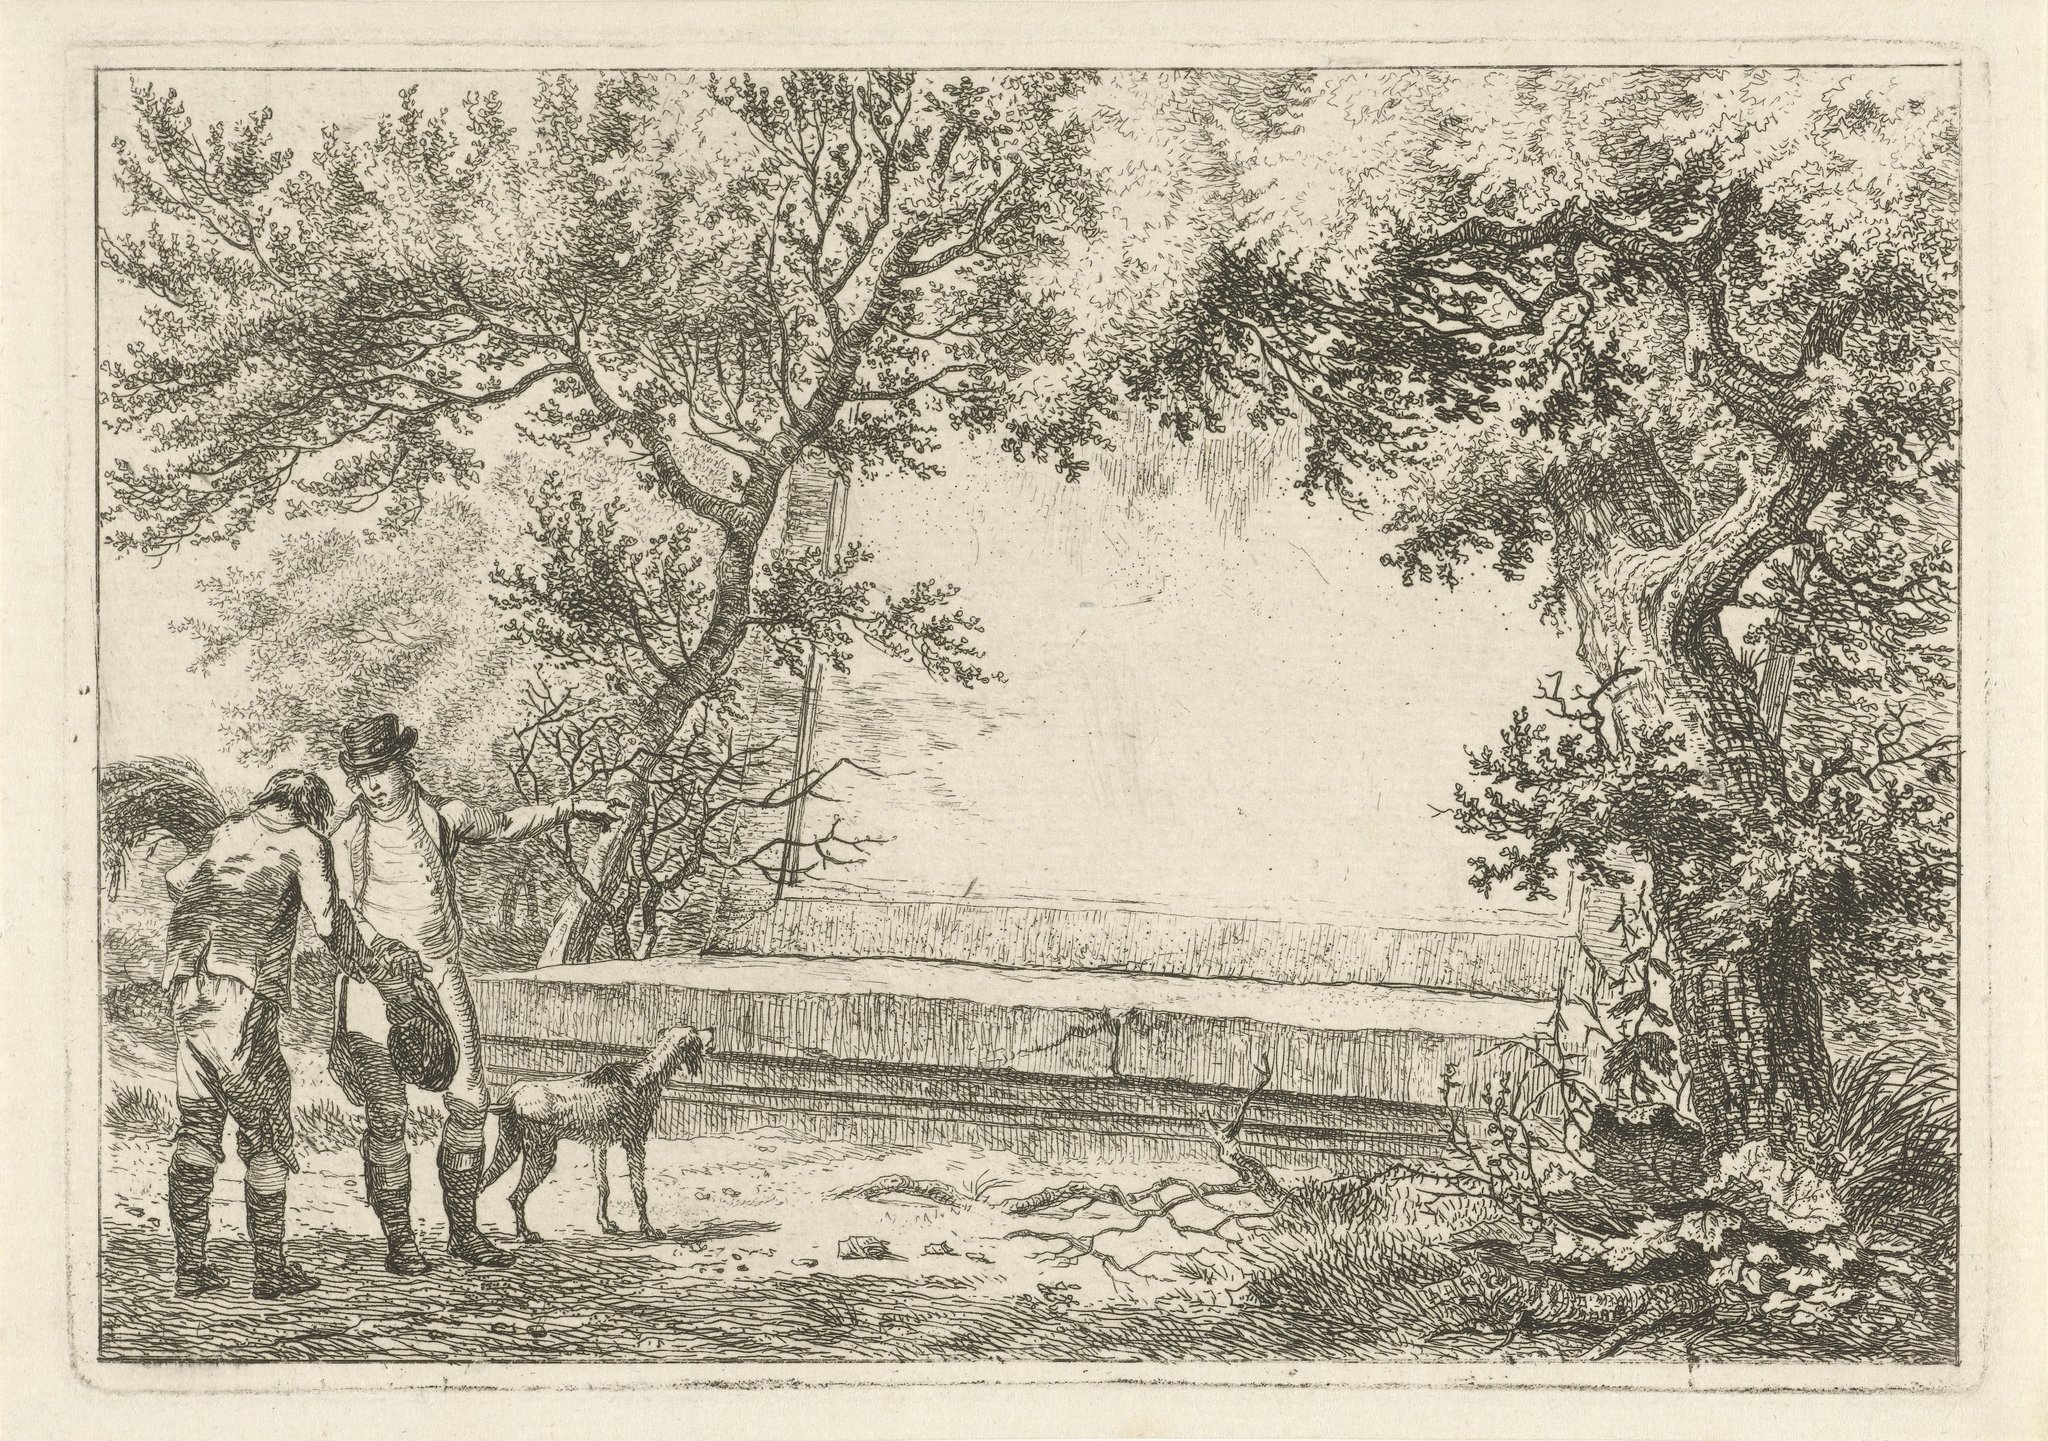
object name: print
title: Twee mannen bij stenen cartouche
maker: hermanus fock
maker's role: conservator, draughtsman, painter, print maker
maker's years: 1766-1822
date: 1801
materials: paper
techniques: etching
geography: amsterdam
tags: baring the head, lifting one's hat, landscapes (+ landscape with figures, staffage)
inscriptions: collector's mark: Lugt 2228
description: Een man met een hond wijst naar een groot stenen cartouche tussen twee bomen. Hij kijkt naar een tweede man die zijn hoed afneemt.